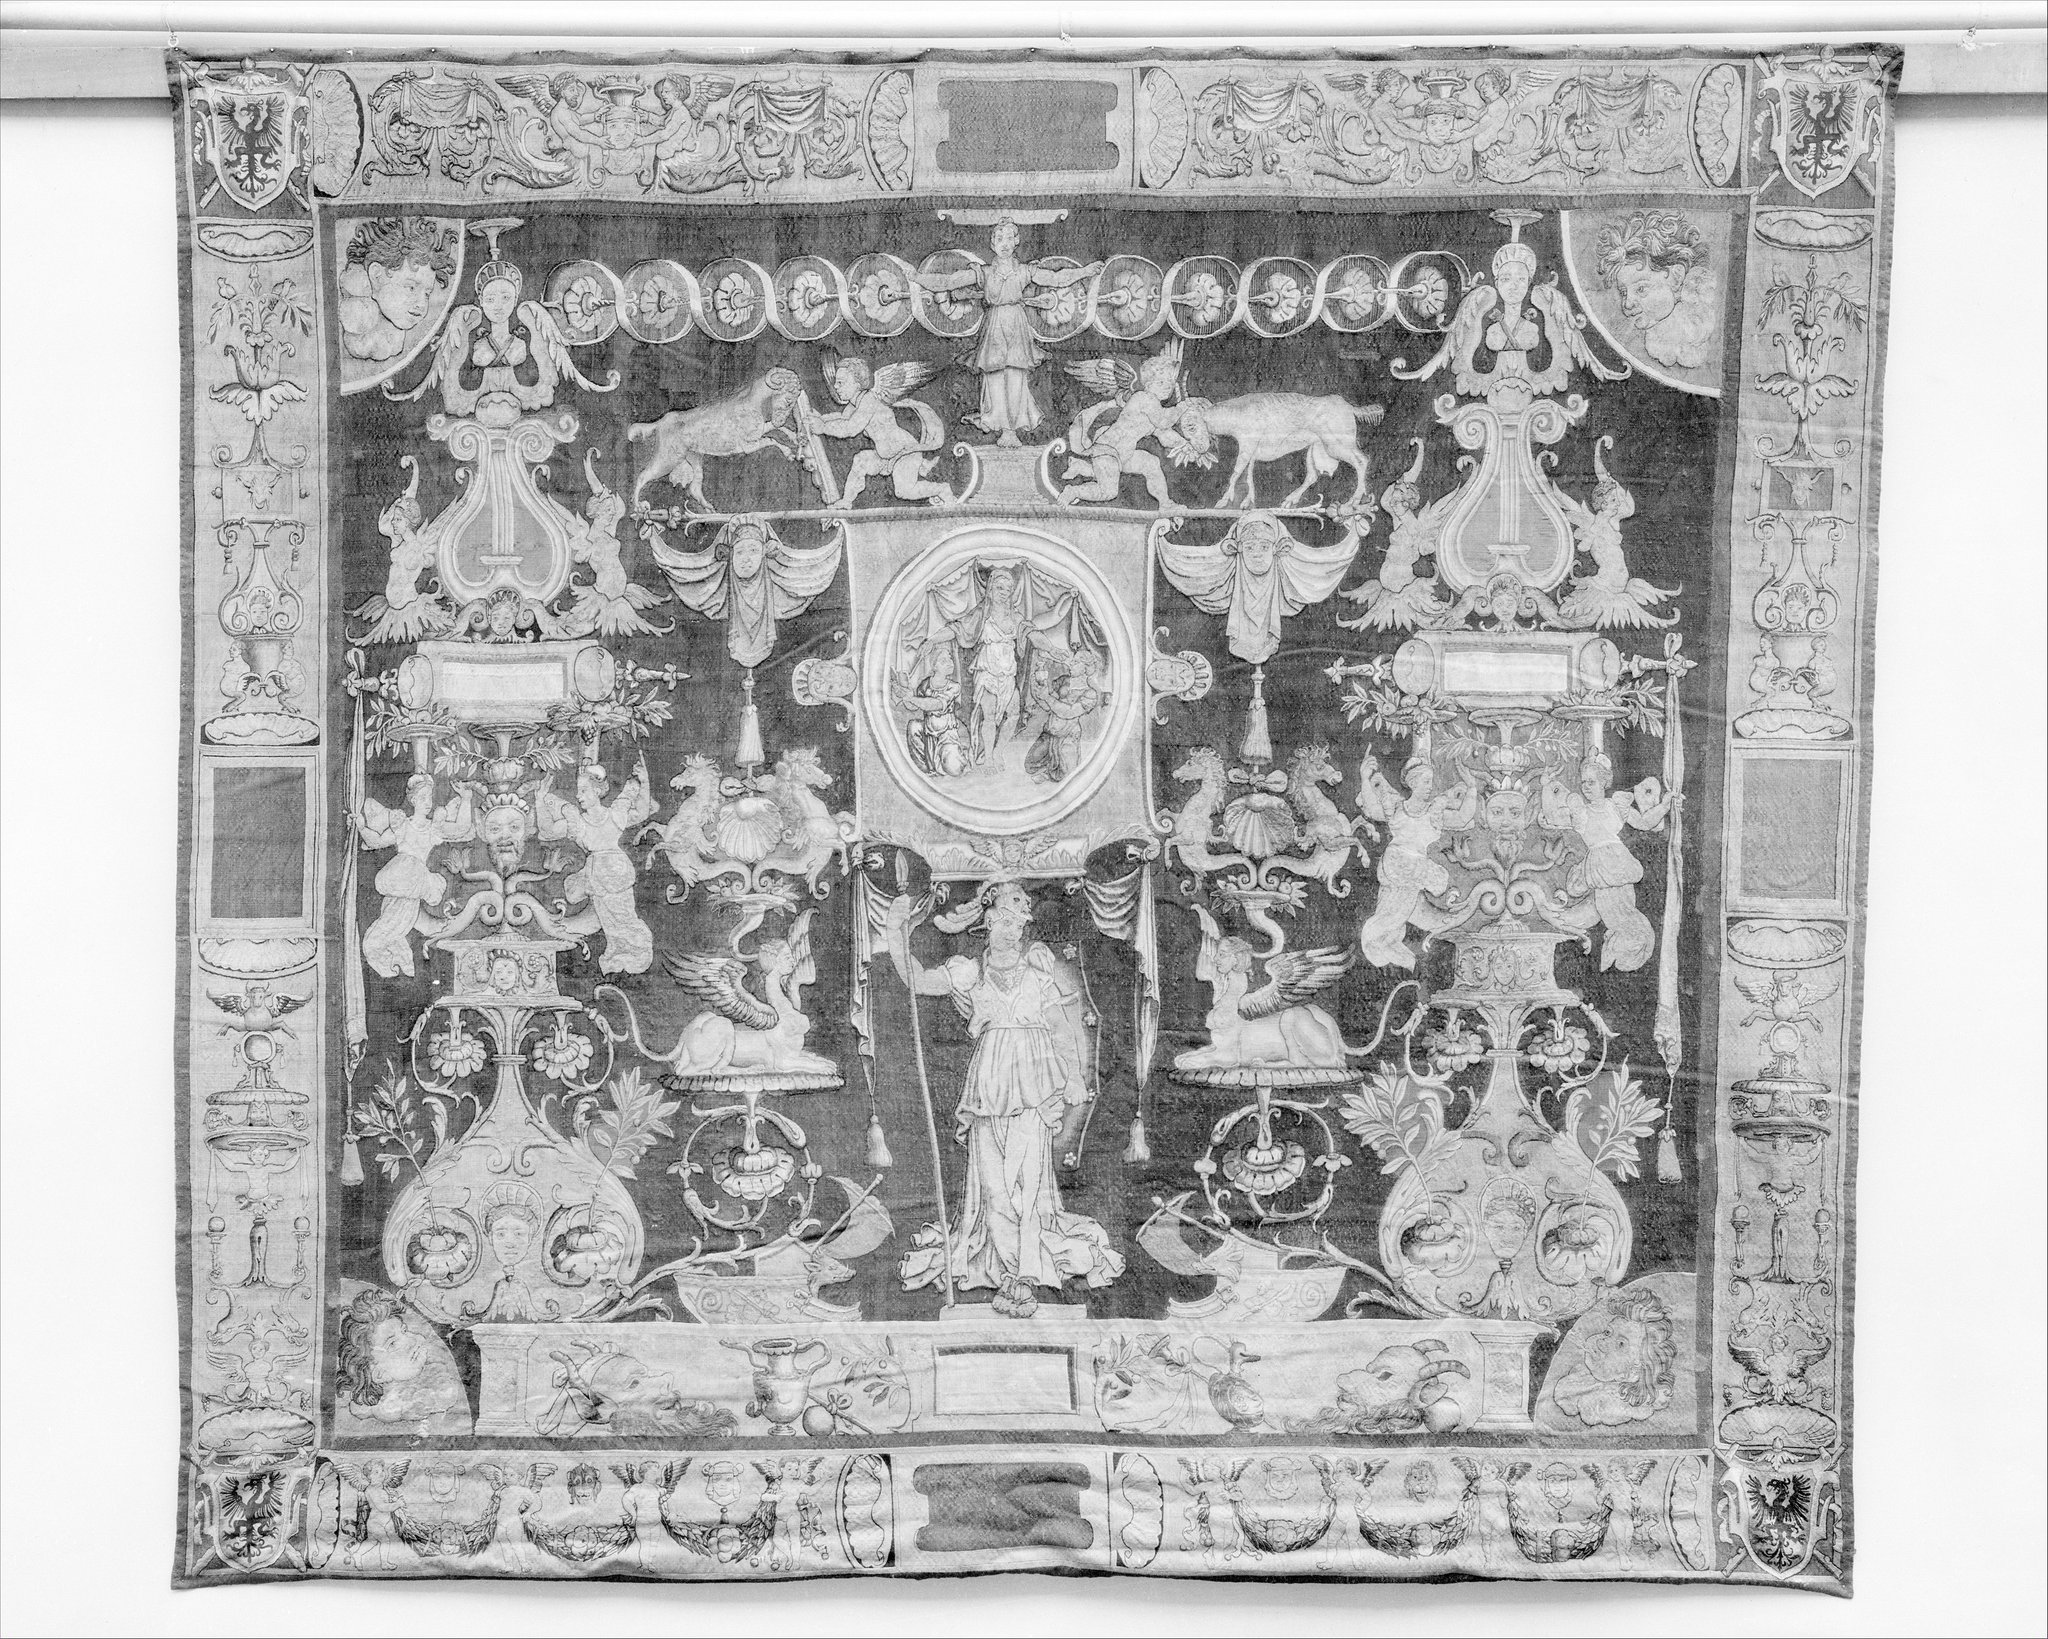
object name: tapestry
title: Minerva from the "Doria Grotesques"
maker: perino del vaga (pietro buonaccorsi)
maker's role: artist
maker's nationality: italian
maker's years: 1501-1547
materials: silk, wool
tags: cupid,mythical creatures,minerva